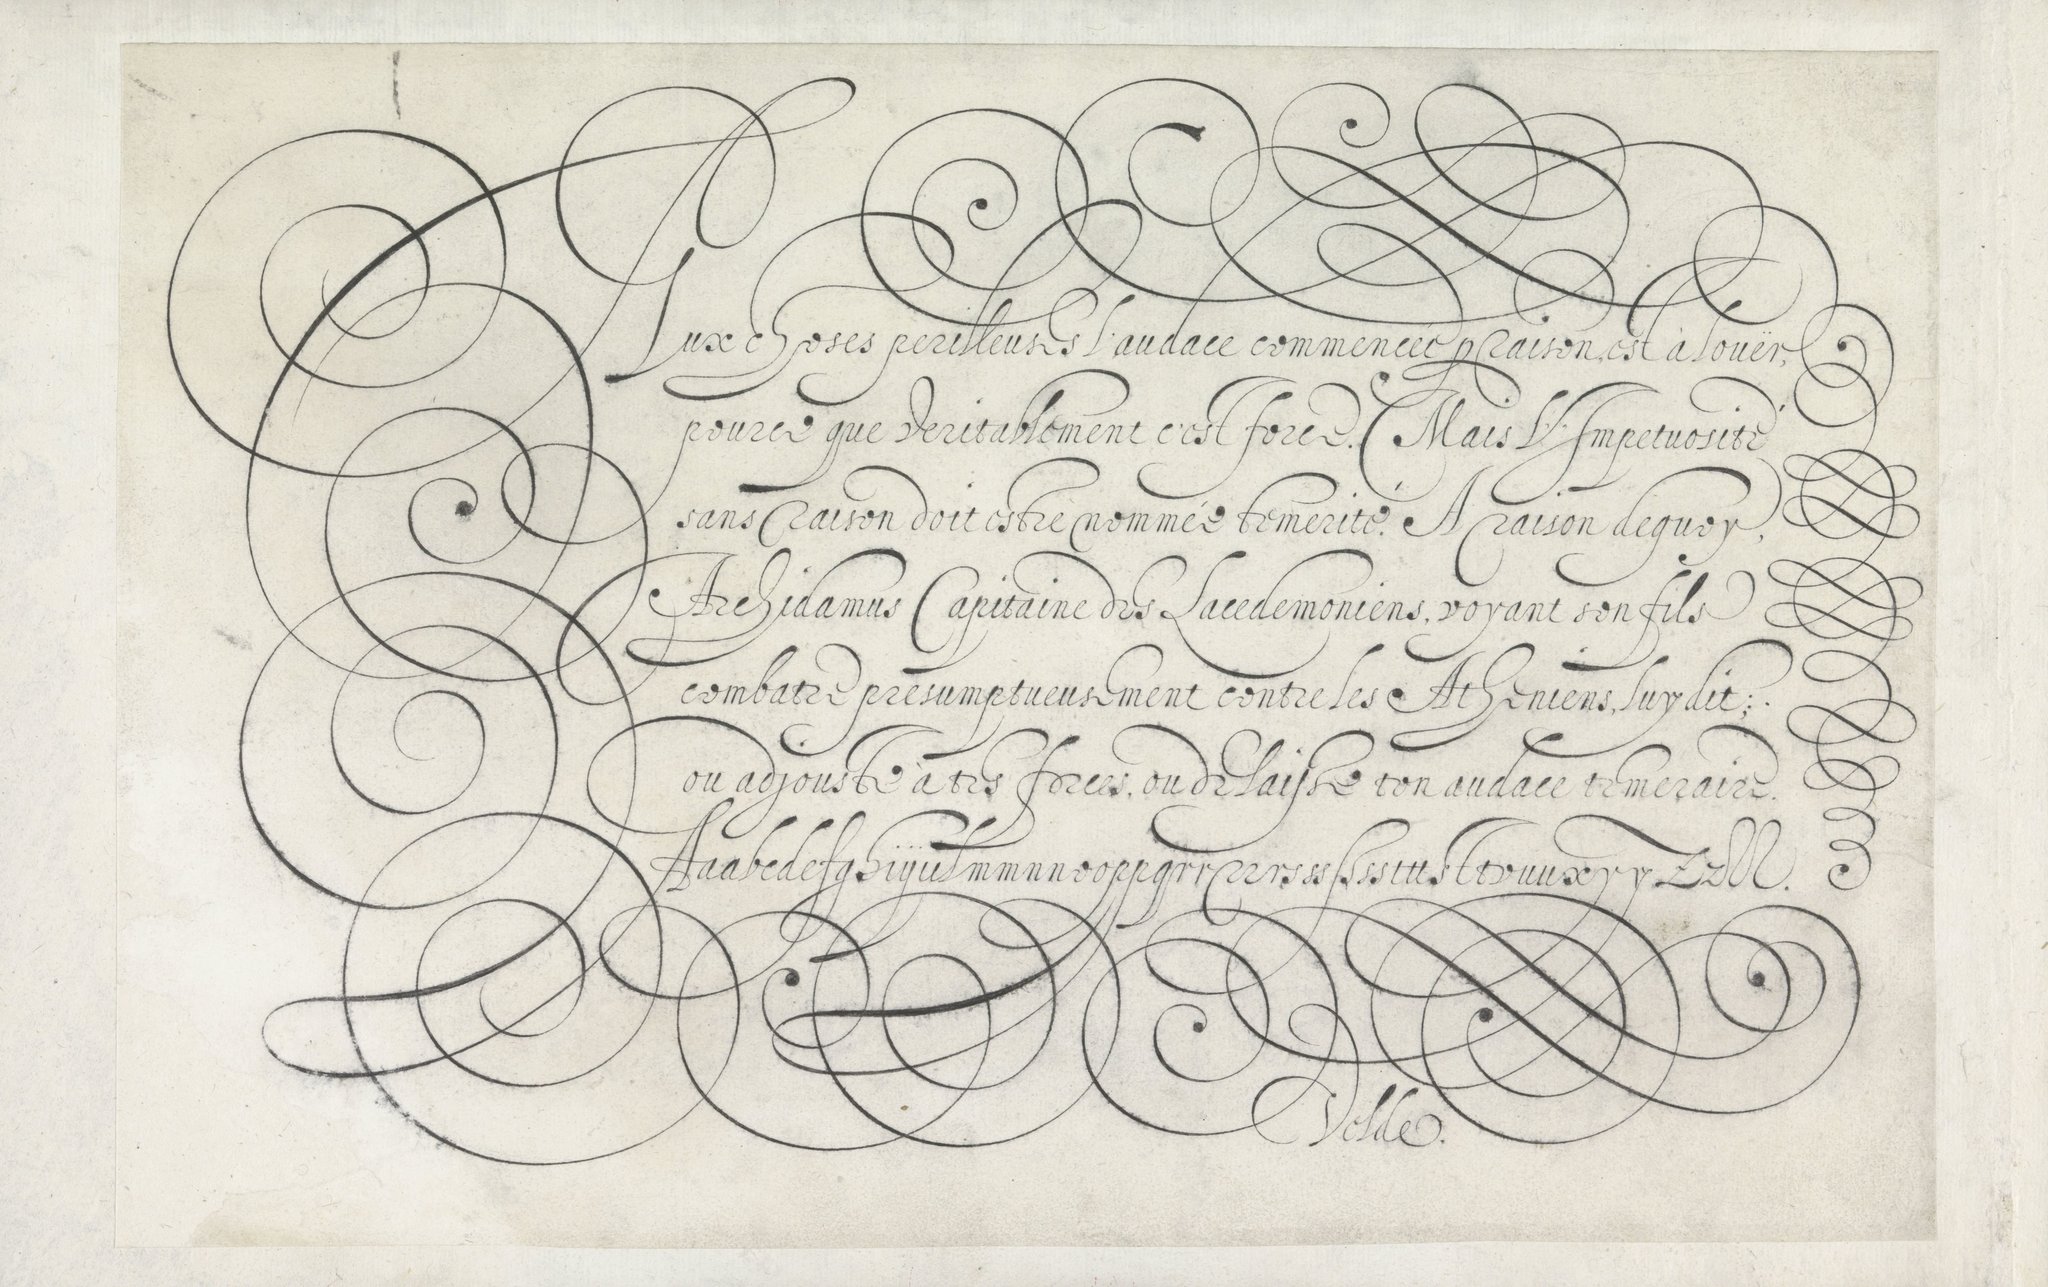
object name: album leaf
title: Ontwerp van een schrijfvoorbeeld: Lux choses perilleuses (...)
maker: jan van de velde (i)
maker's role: painter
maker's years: 1568-1623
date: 1605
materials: ink, paper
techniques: calligraphy, pen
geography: rotterdam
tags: calligraphy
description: Kalligrafische tekening met zeven regels tekst in het Frans: Lux choses perilleuses ... De tekst is omlijst met krulwerk. De tekening maakt deel uit van een album.